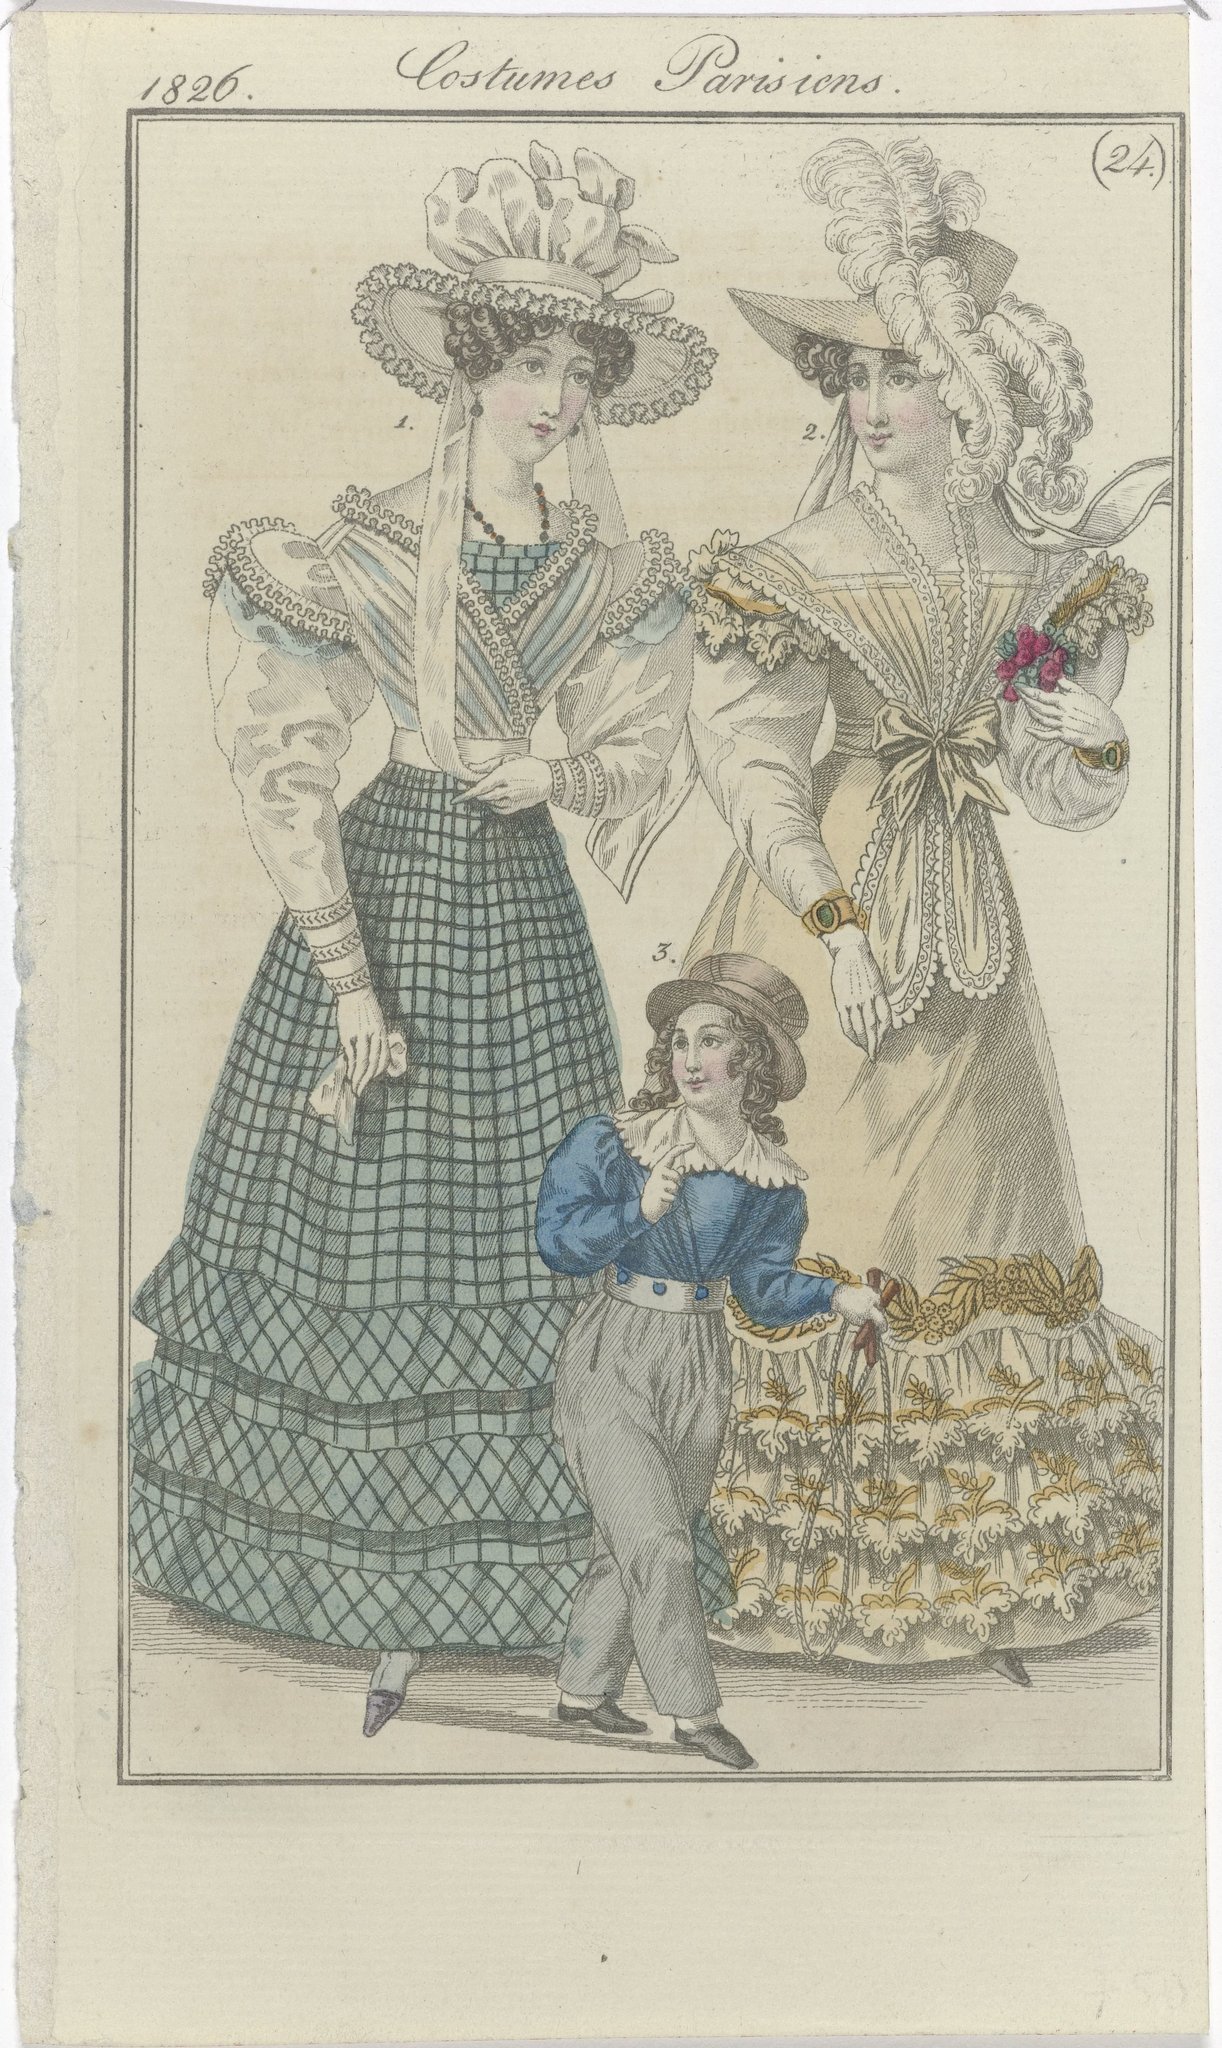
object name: fashion print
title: Journal des Dames et des Modes, editie Frankfurt 1826, Costumes Parisiens, (24)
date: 1826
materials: paper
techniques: engraving, hand coloring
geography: frankfurt am main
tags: clothing for the upper part of the body (+ women's clothes), cut flowers; nosegay, bunch of flowers, trousers, breeches (+ boys' clothes), head-gear: hat (+ boys' clothes), fashion plates, head-gear: hat (+ women's clothes), dress, gown (+ women's clothes), fan (+ women's clothes), jumping-rope games, bracelet, wristlet (+ women's clothes)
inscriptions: title: ‘Costumes Parisiens’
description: Twee vrouwen, genummerd 1 en 2, gekleed in japonnen met canezou. De jongen, nummer 3, is een aangepaste kopie (hier met de arm naar beneden) naar Pl. 388, 1826, Petit Courrier des Dames. Hij draagt een matrozenpak van geitenwol. Hoed of 'chapeau casquette' van 'crin'. Springtouw in de hand. Prent uit het modetijdschrift Journal des Dames et des Modes, Frankfurt-am-Main, 1798-1848.